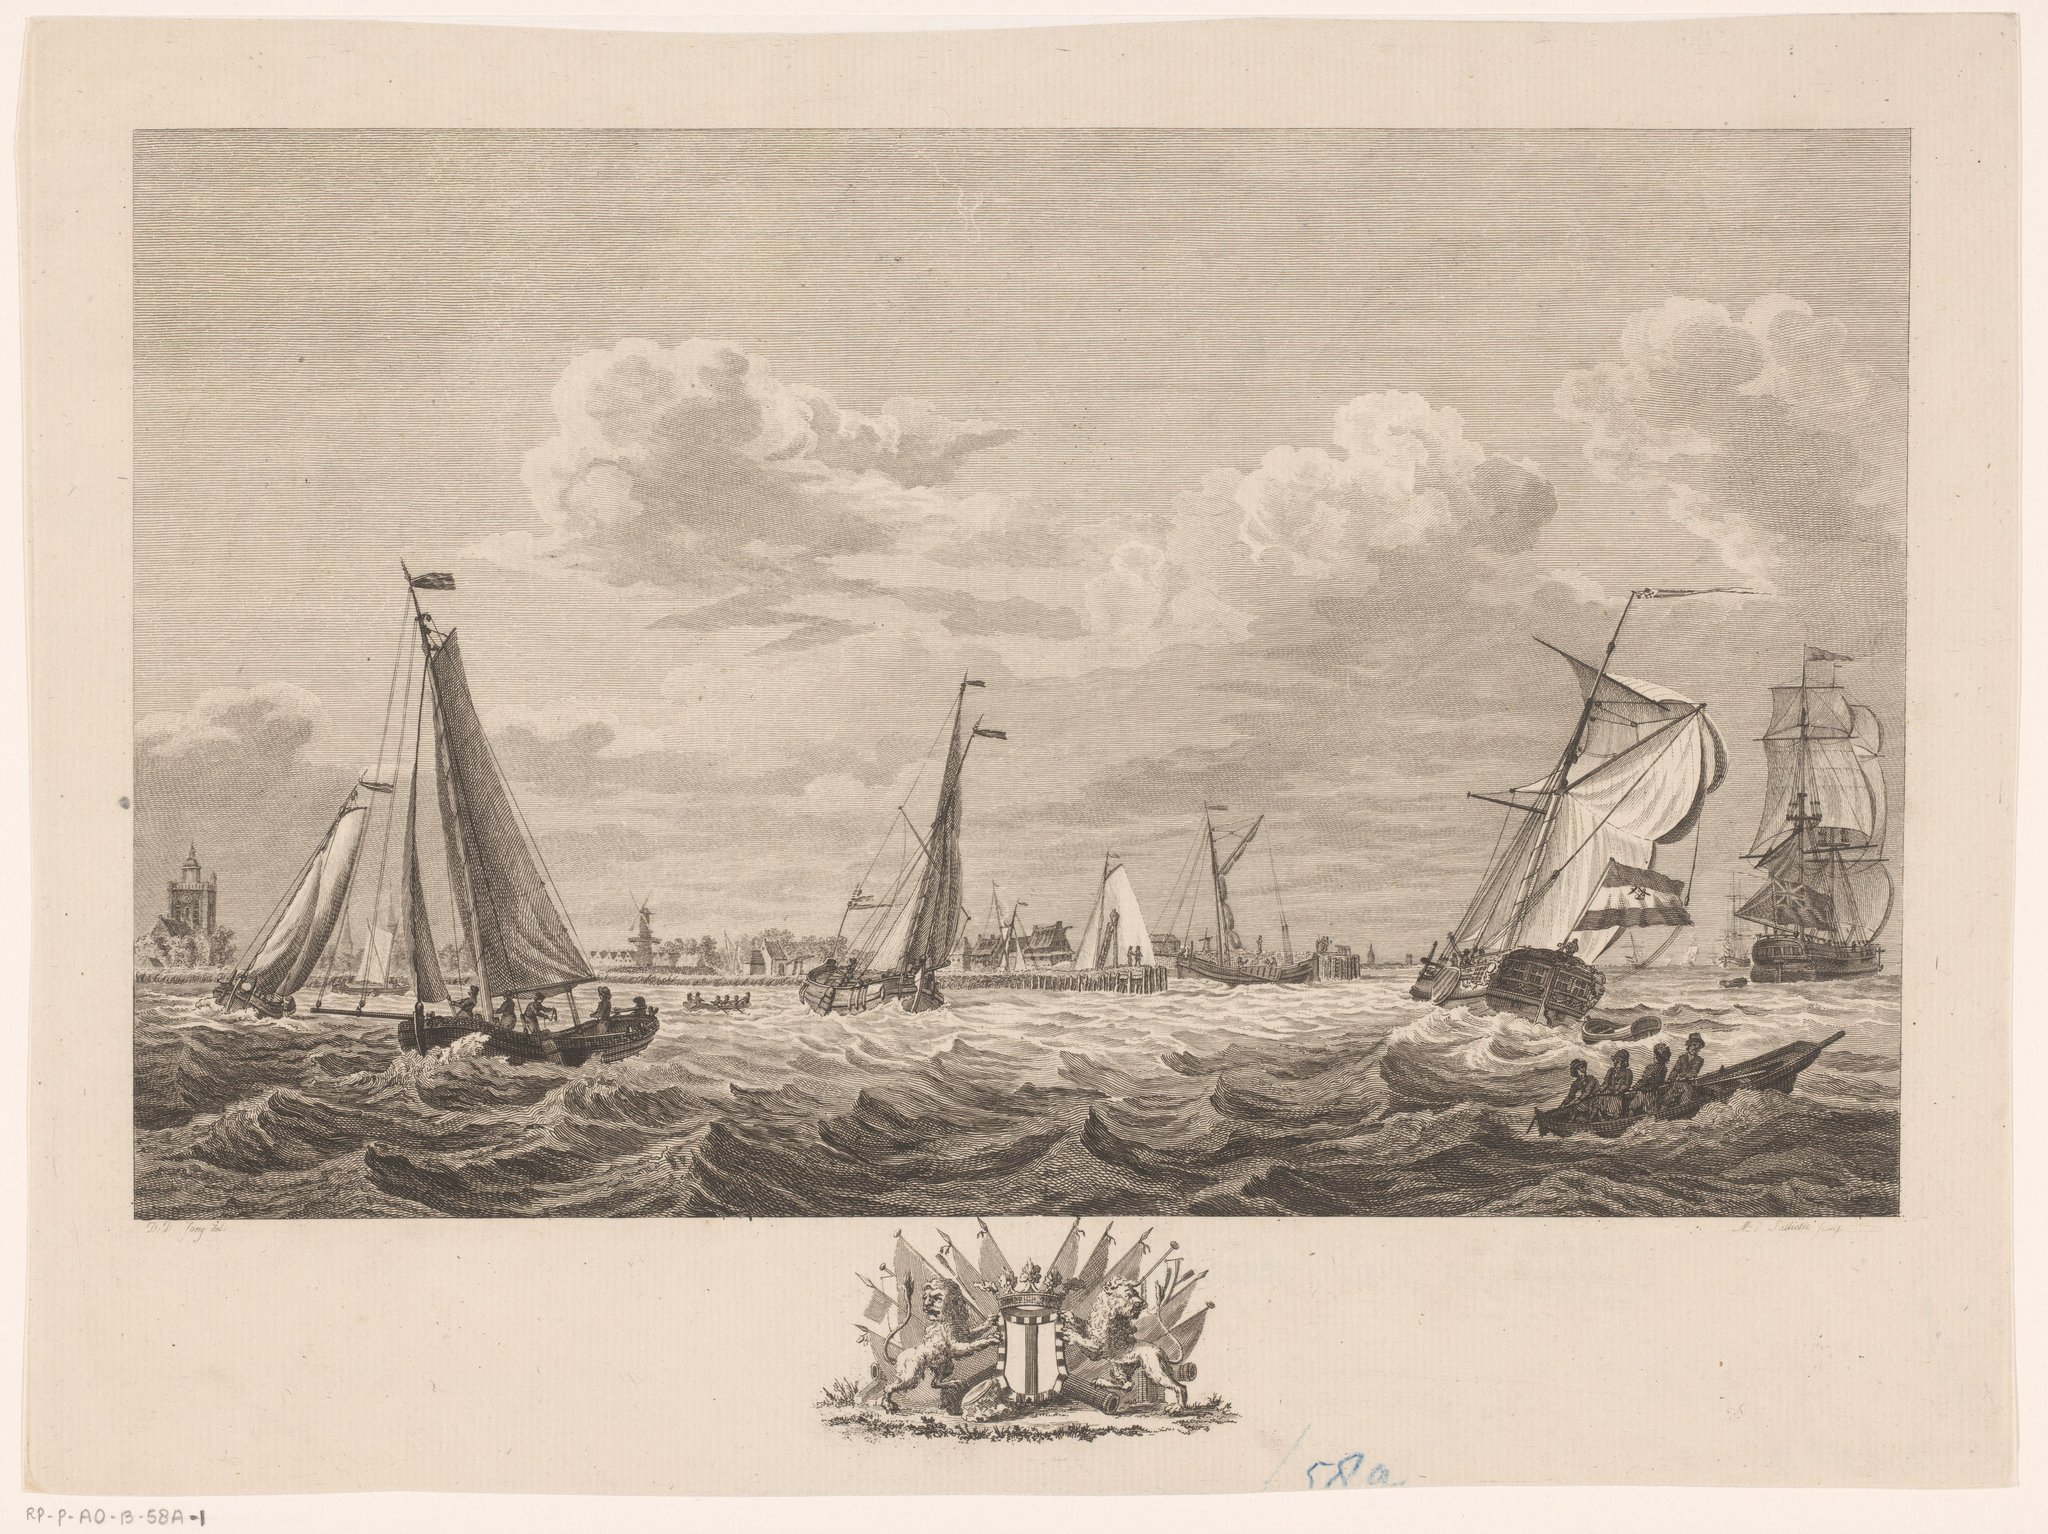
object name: print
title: Gezicht op de haven van Brielle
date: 1779-1787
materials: paper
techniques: etching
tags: harbour, coat of arms (as symbol of the state, etc.) (+ city; municipal), sailing-ship, sailing-boat, brielle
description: Zie RP-P-AO-13-58A-2 voor latere staat. Nog latere staat ook gebruikt in: Aa, Cornelis van der. Atlas van de zeehavens der Bataafsche Republiek. Met derzelver beschrijvingen in XXXI kunstplaaten / Atlas van de zeehavens der Bataafsche Republiek, die van Batavia en Onrust. Mitsgaders de afbeeldingen van de haringvisscherij en de walvischvangst (…). Amsterdam: Evert Maaskamp, 1805.